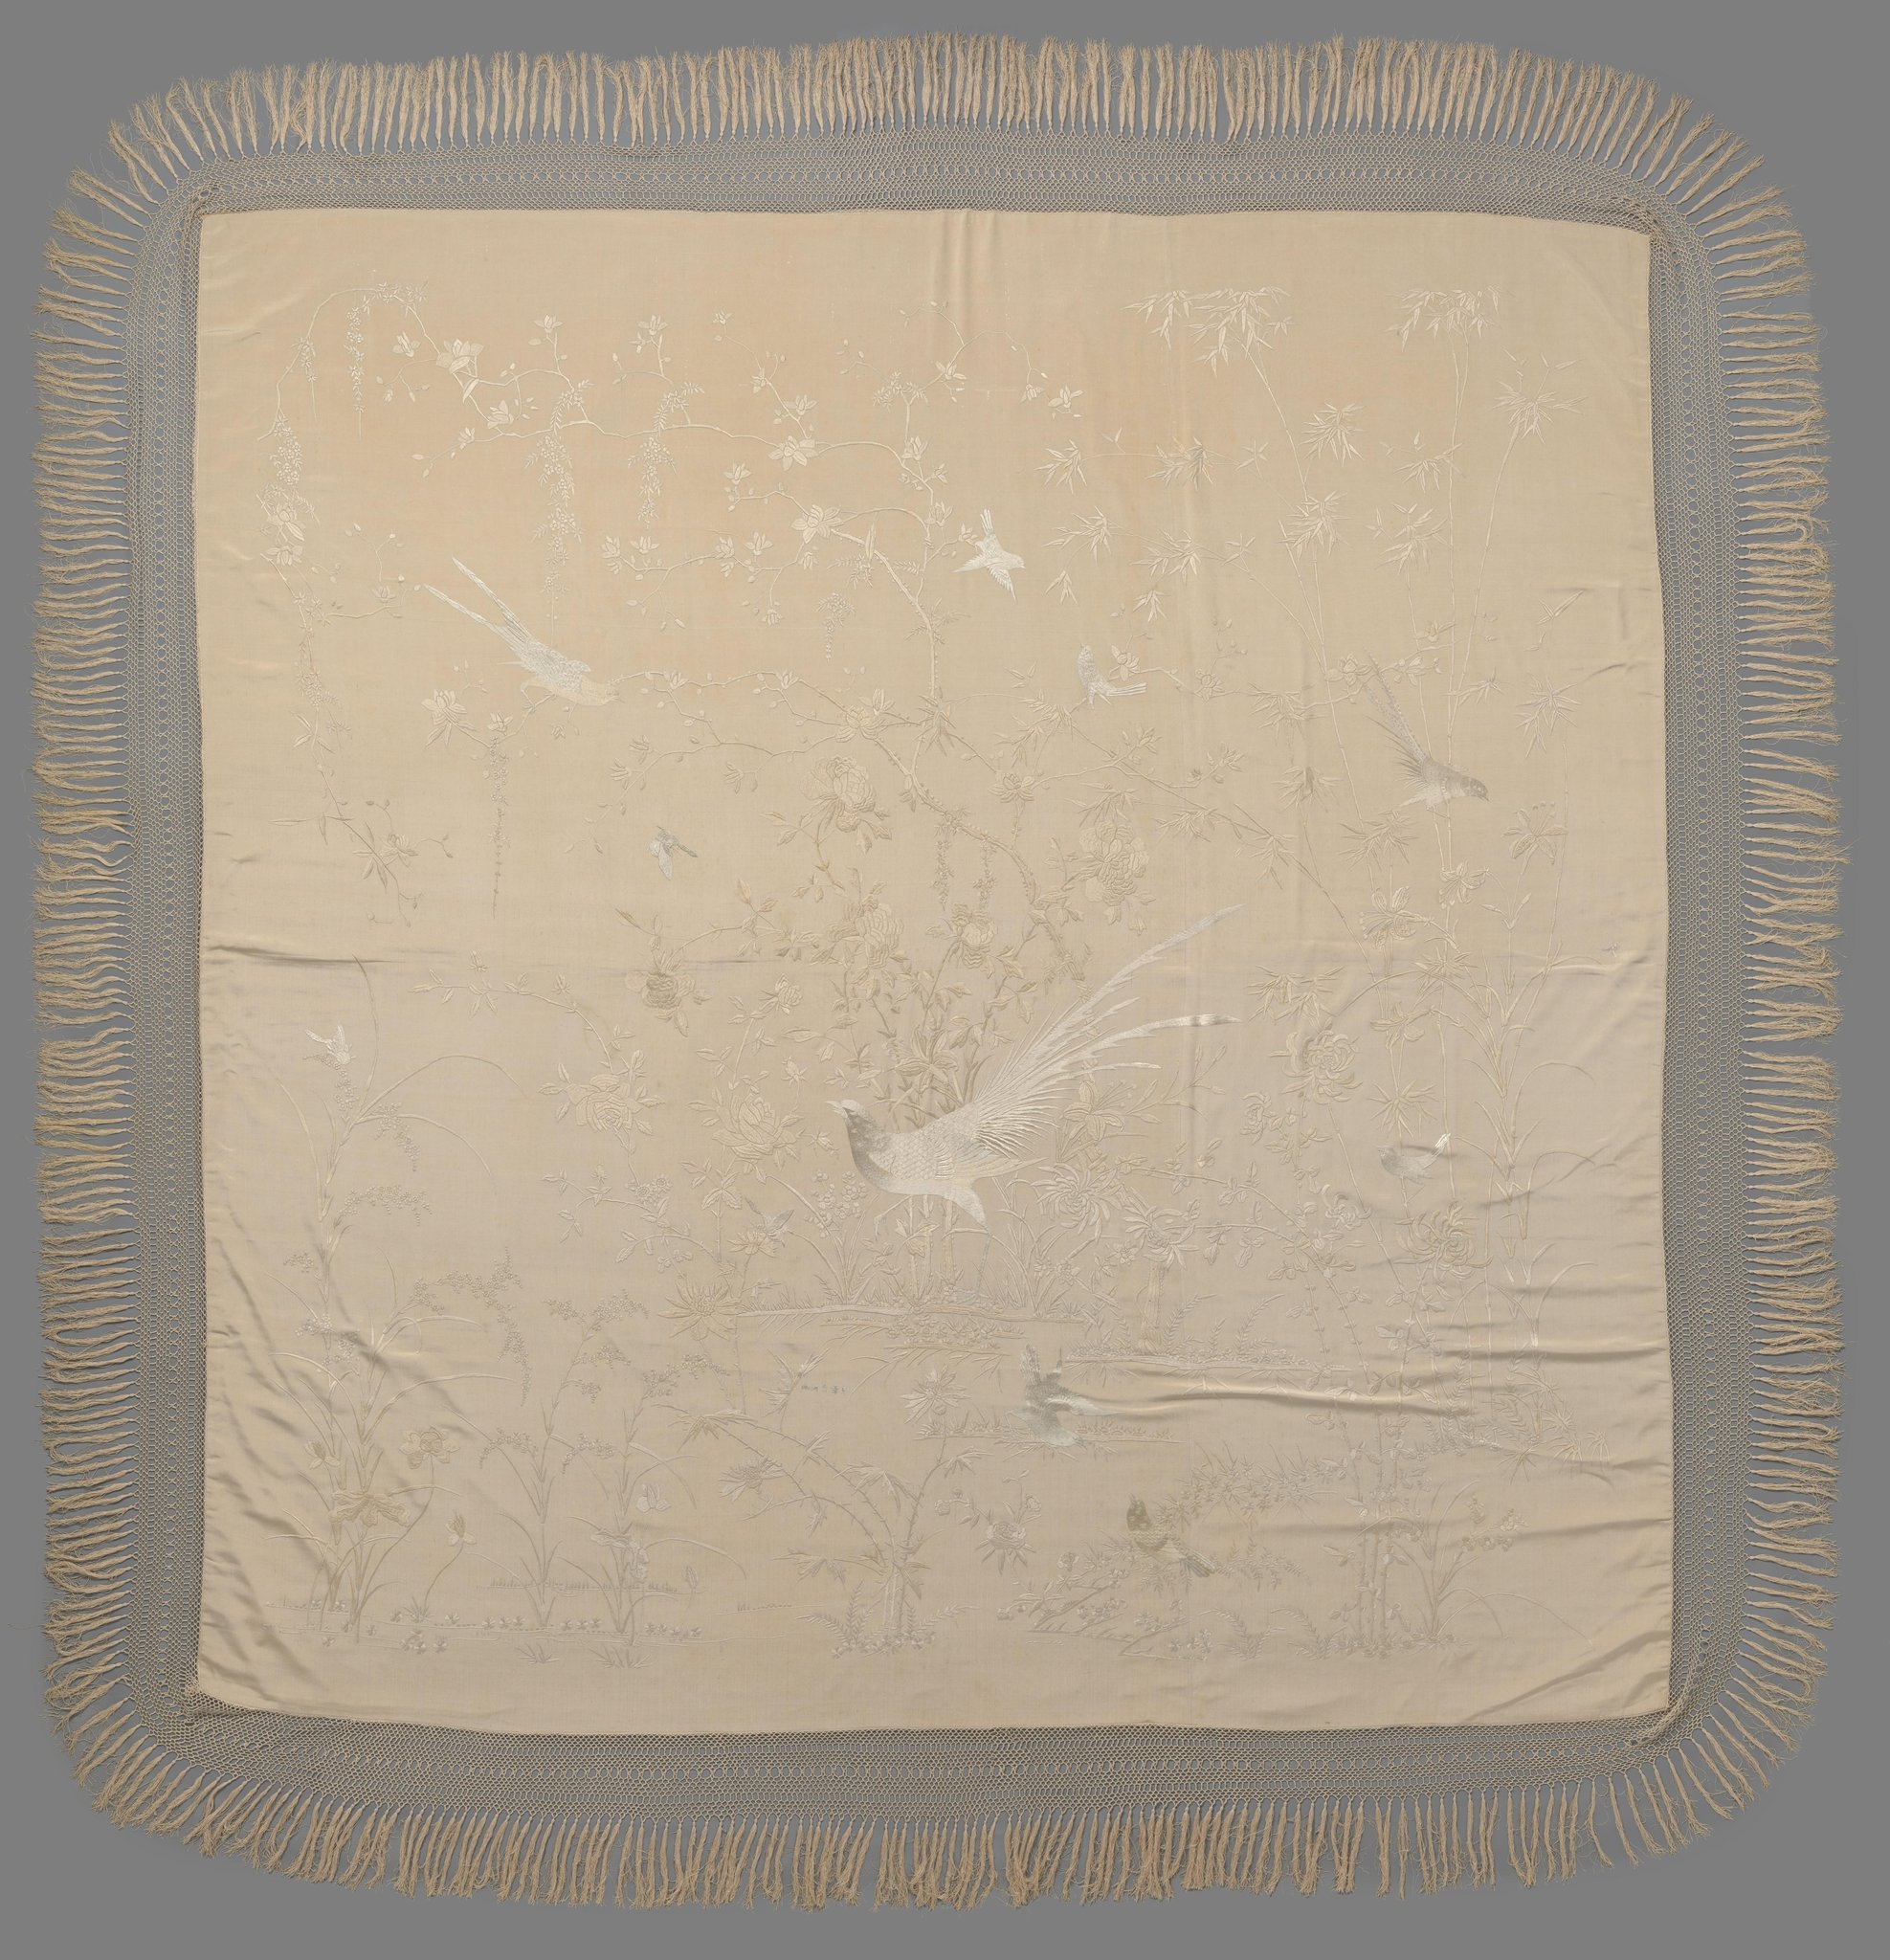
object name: bedspread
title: White bed cover embroidered in white with a design of flowers and birds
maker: Anonymous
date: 1900-1915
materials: silk, textile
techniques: embroidered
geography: guangdong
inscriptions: mark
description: This bedspread is decorated with embroidered flowers, plants and birds. Unlike the usual colourful Chinese embroidery, only white is used here. The bedspread was a wedding gift to the Dutch woman Theodora Leijh when she married Soedianto Notobroto, a Javanese prince, in 1916. The white embroidery was probably ordered especially for this occasion.